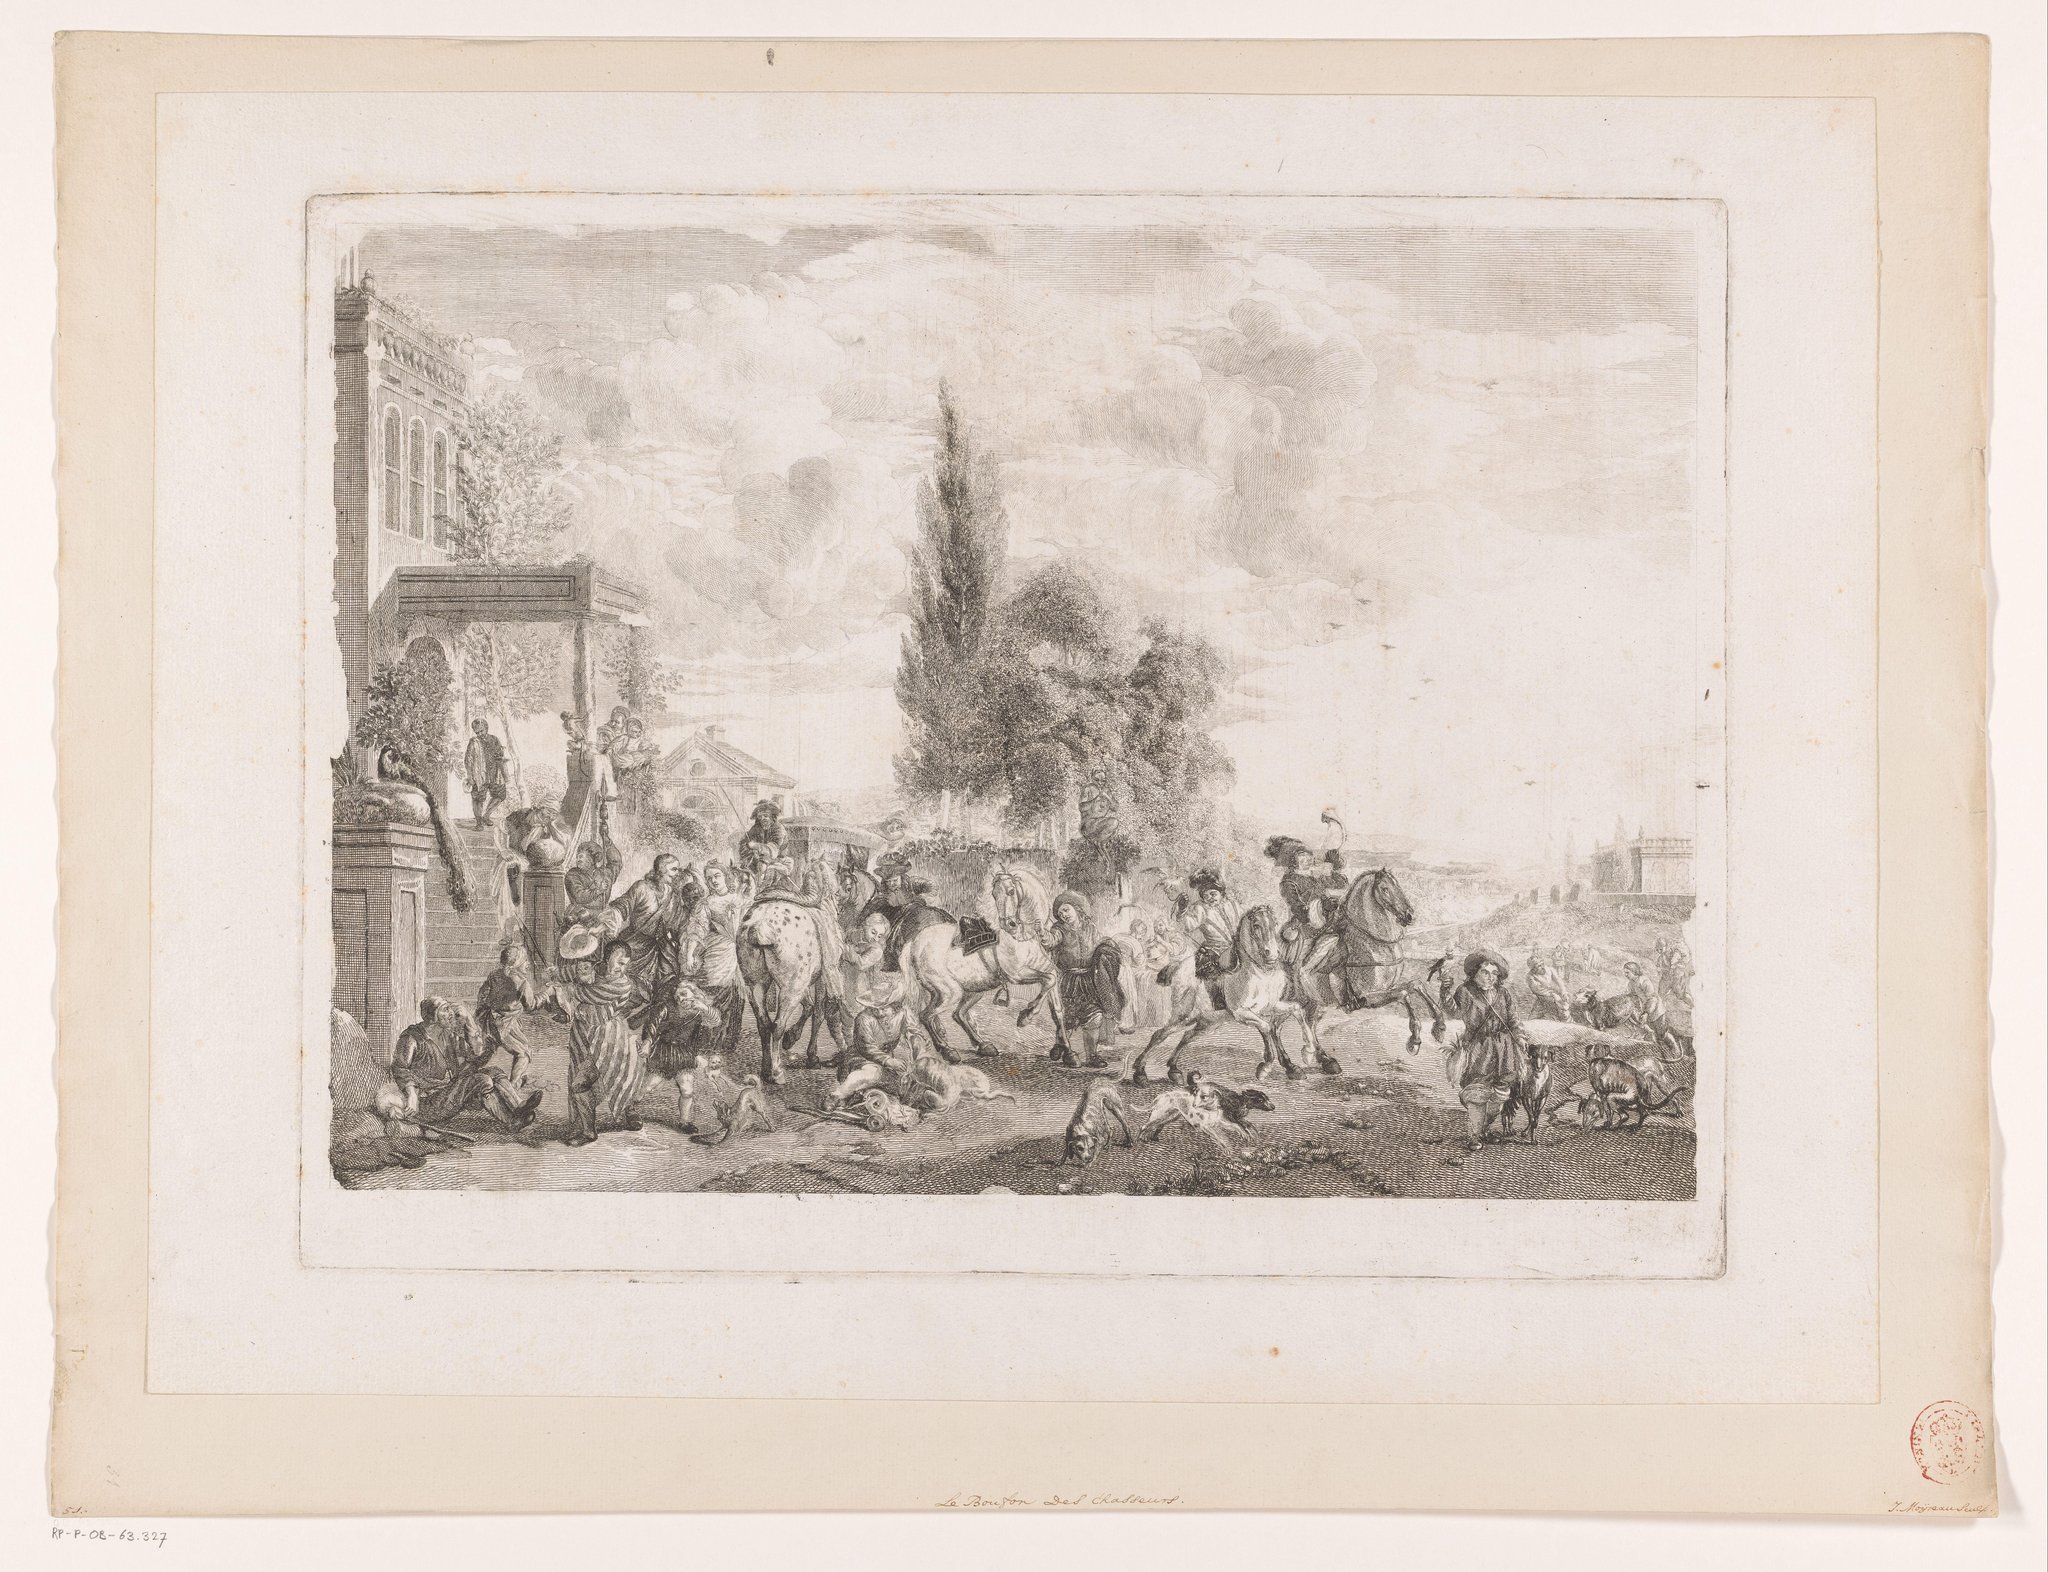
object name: print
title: Verzamelend jachtgezelschap voor een huis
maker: jean moyreau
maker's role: print maker, publisher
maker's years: 1690-1762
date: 1746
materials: paper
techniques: etching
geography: france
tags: assembling, 'départ pour la chasse'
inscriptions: collector's mark: Lugt 240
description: Maakt deel uit van een serie van 89 prenten te dateren tussen ca. 1733-1762, naar het geschilderde oeuvre van Philips Wouwerman. Dit betreft plaat 51.